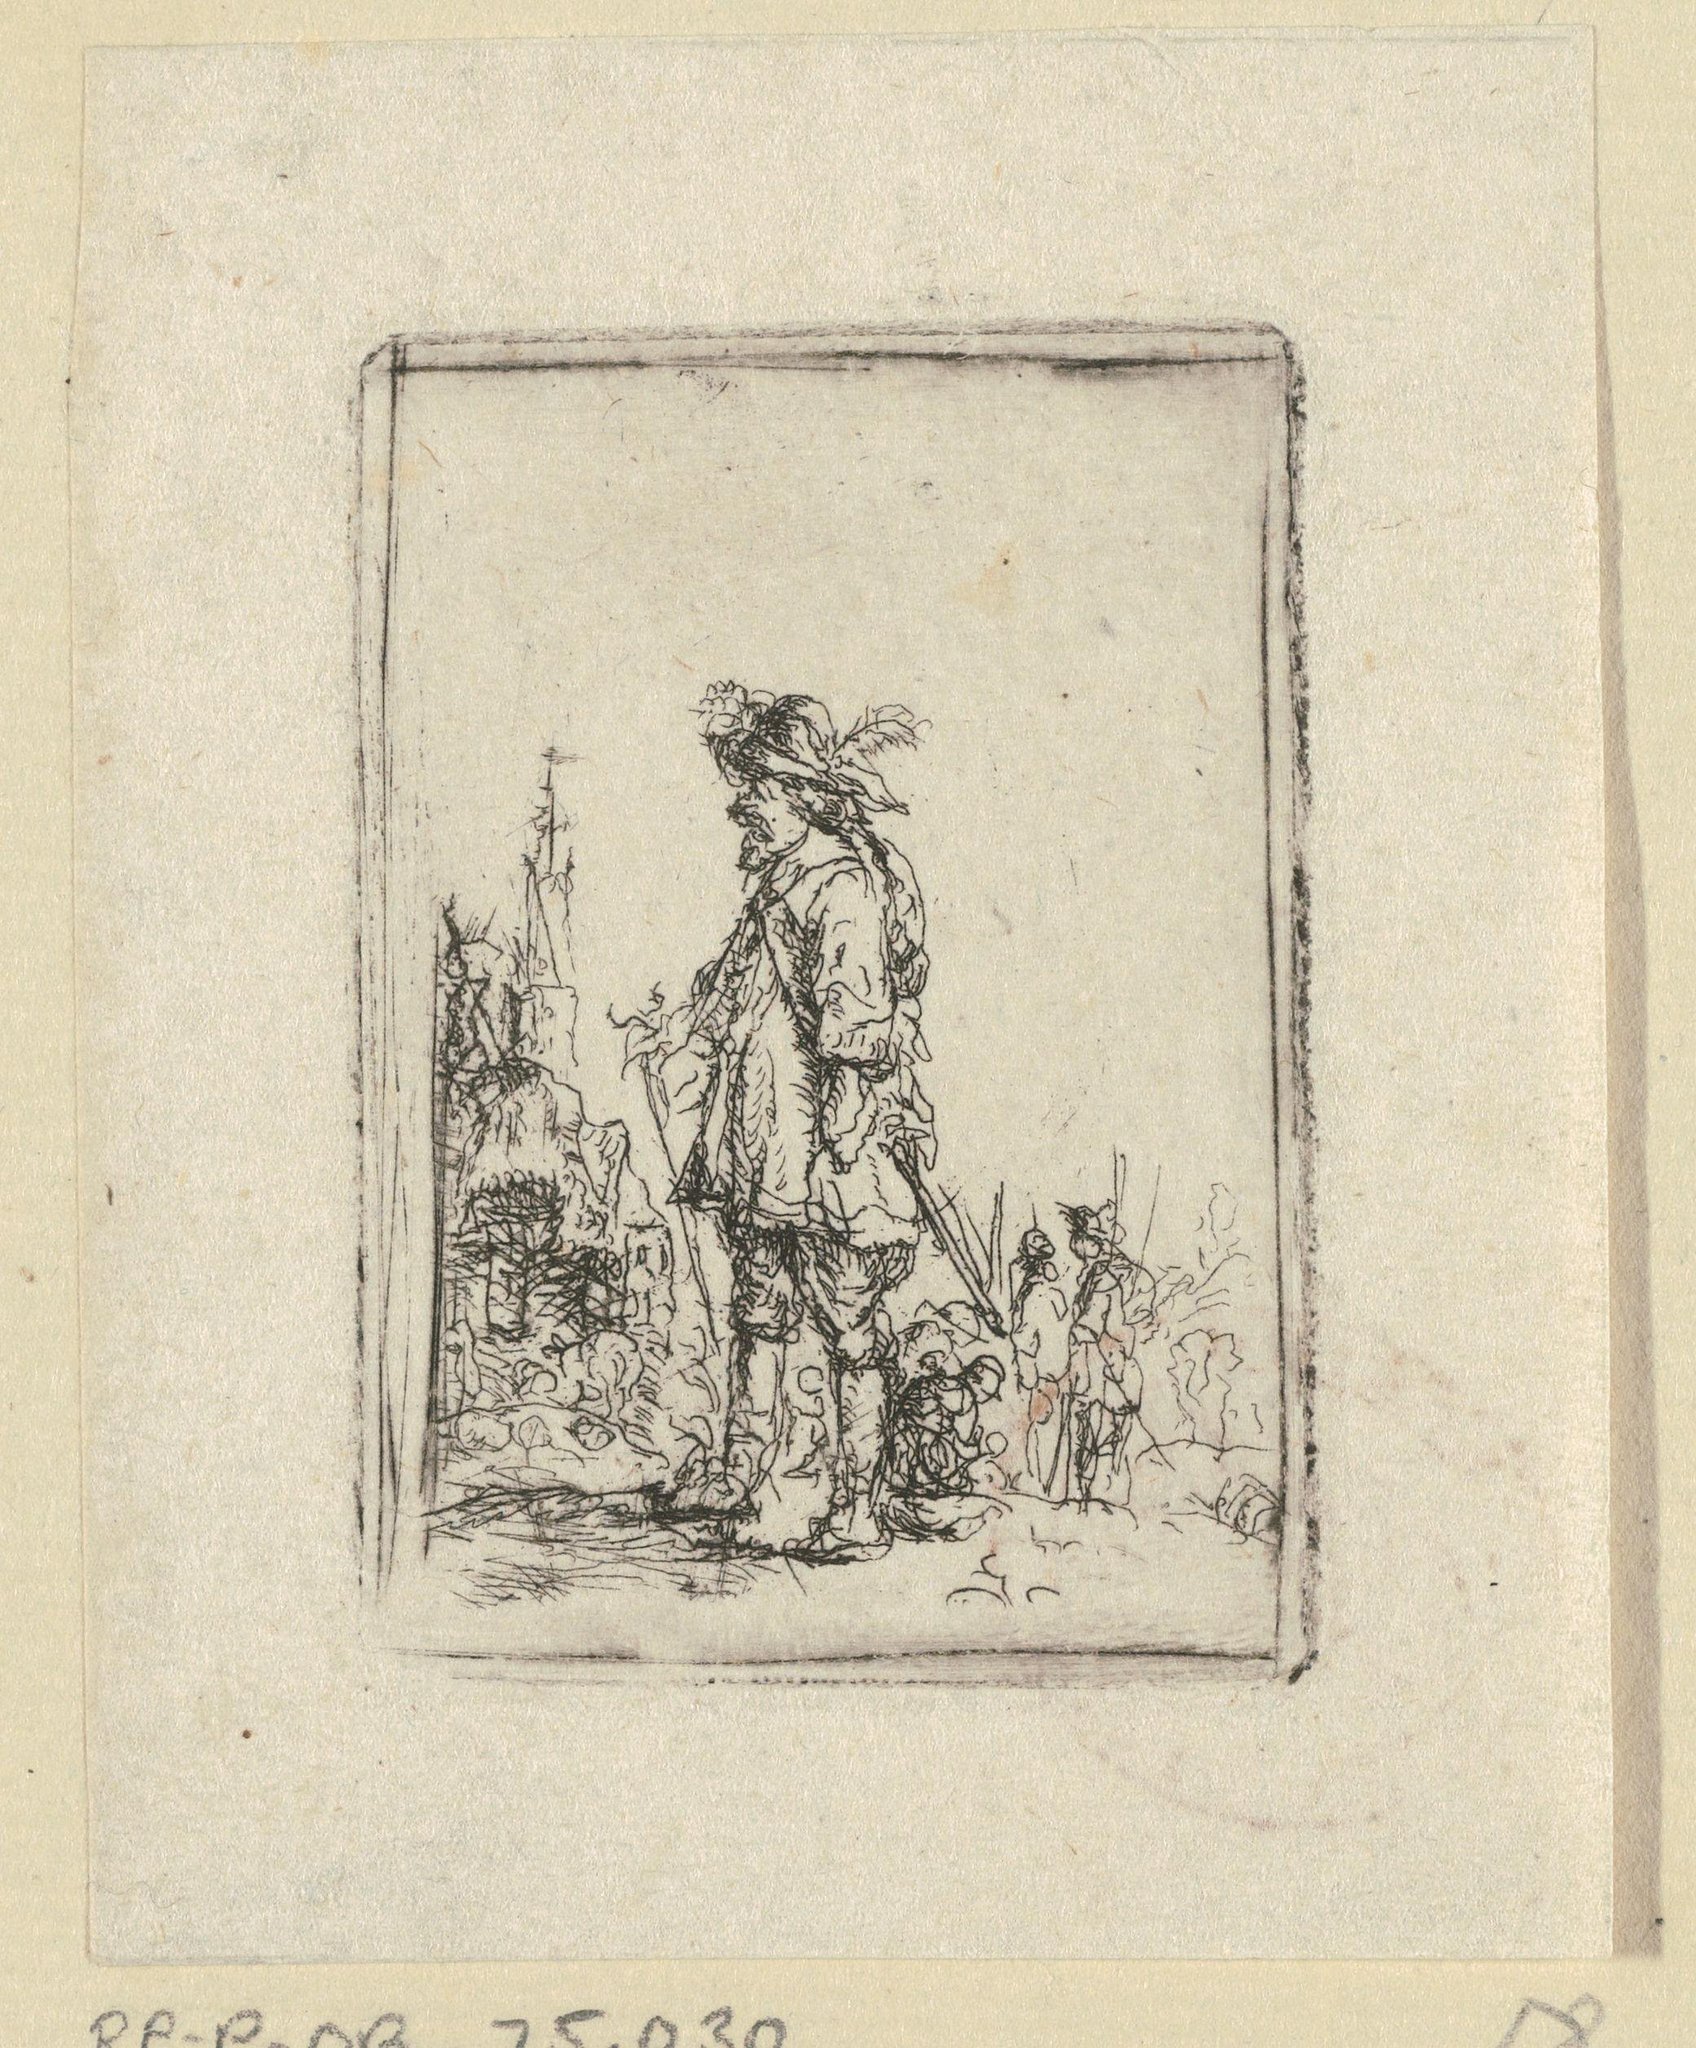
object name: print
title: Staande militair naar links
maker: Anonymous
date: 1600-1700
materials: paper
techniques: etching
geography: netherlands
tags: official; civil servant; functionary (in general), private soldier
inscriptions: collector's mark: Lugt 240